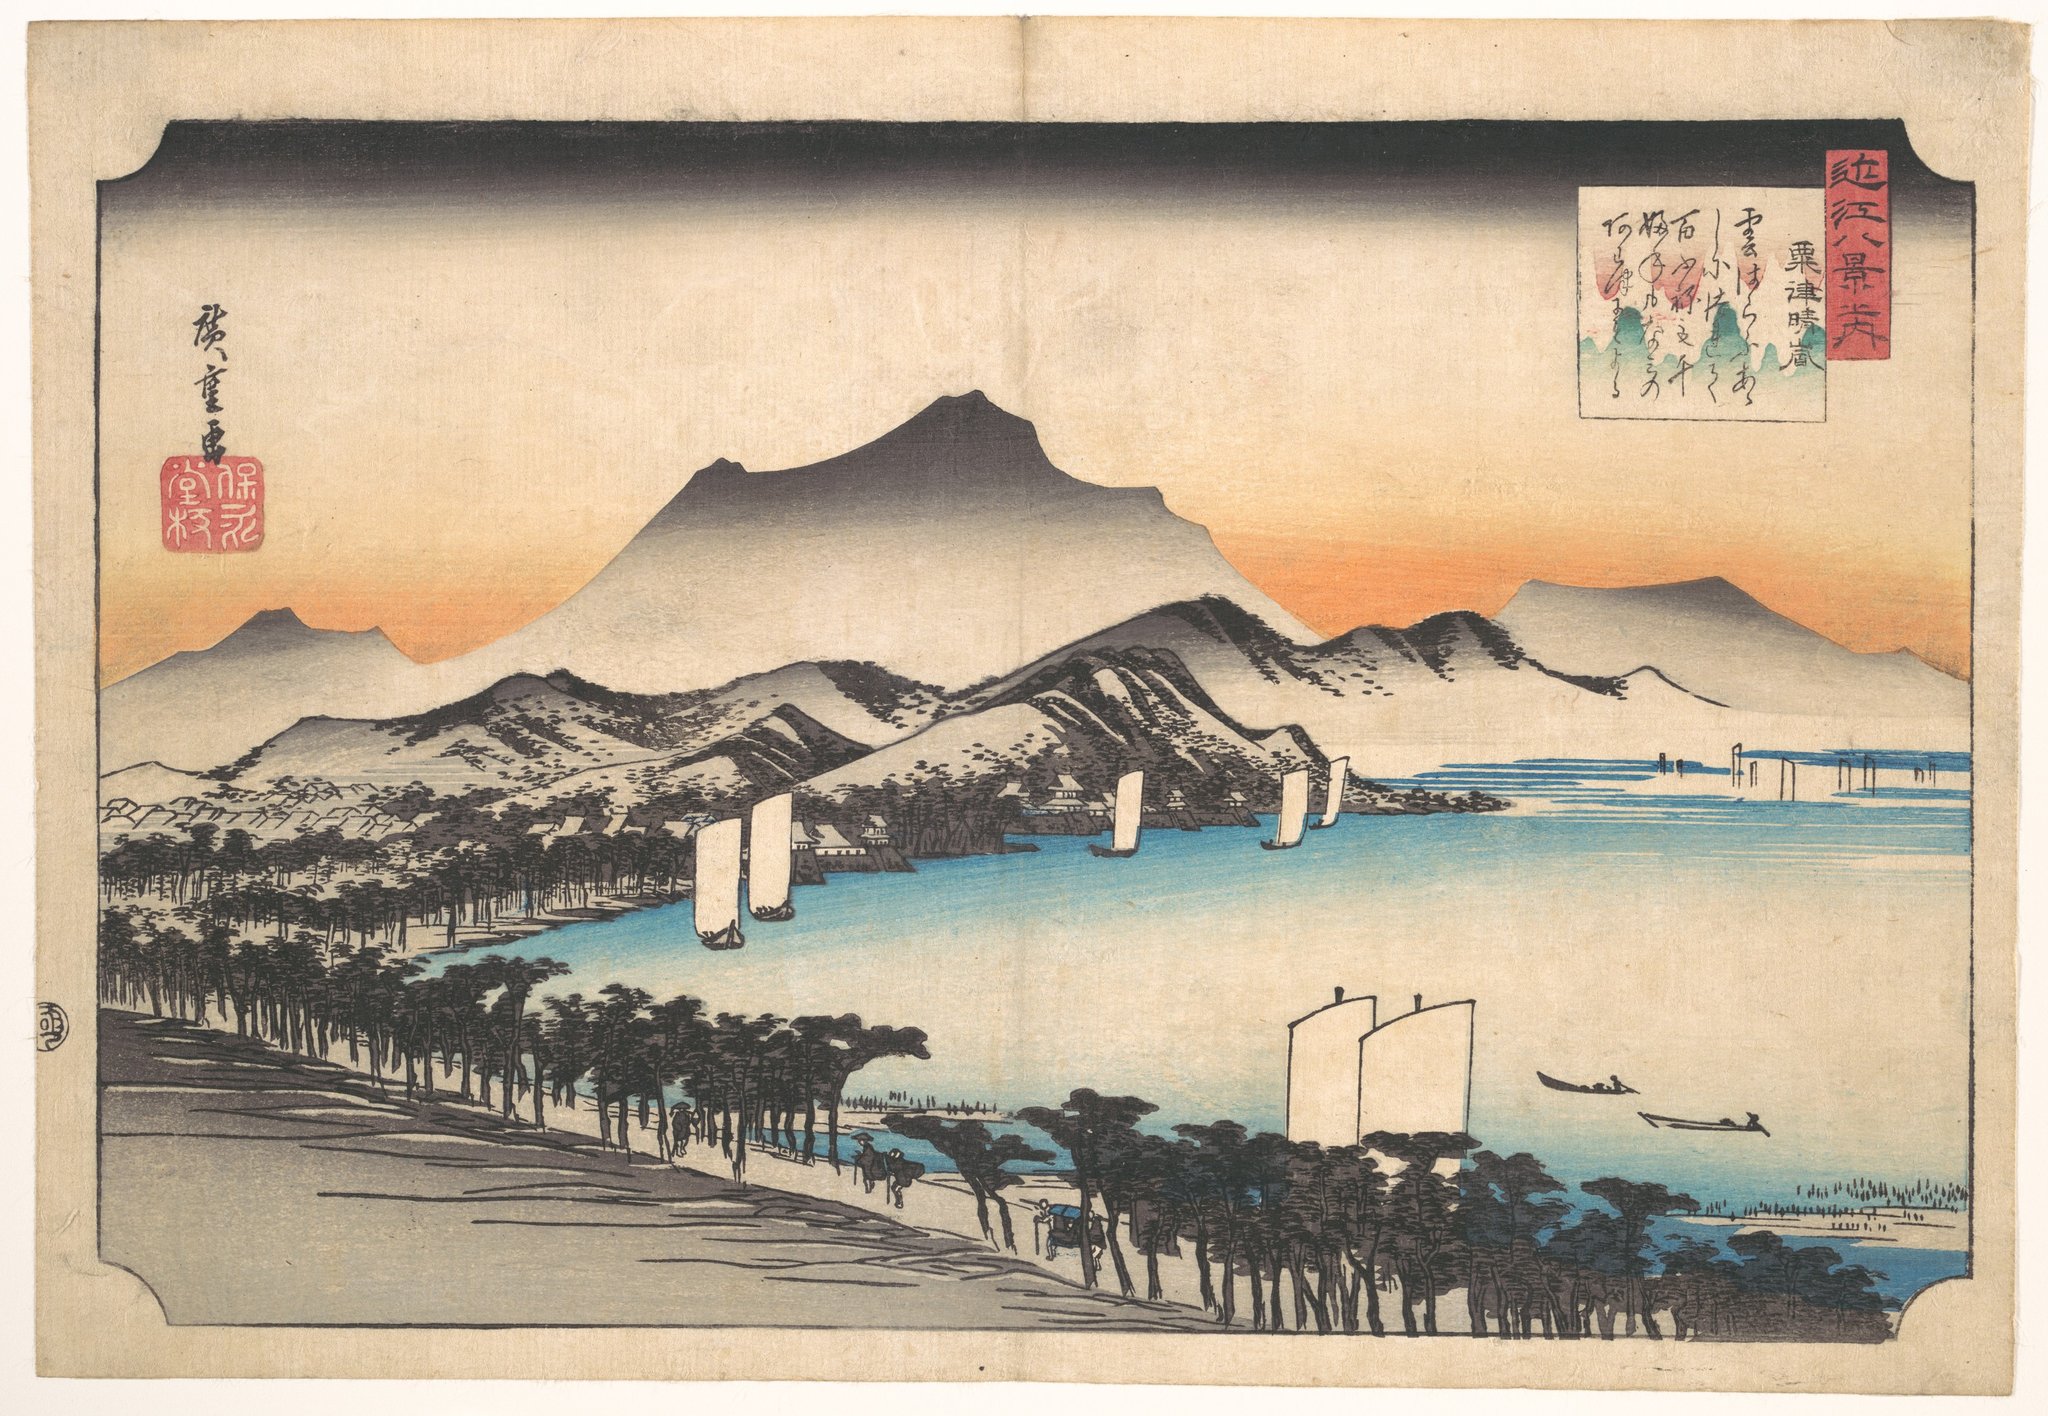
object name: print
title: Clearing Weather at Awazu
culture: japanese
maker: utagawa hiroshige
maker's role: artist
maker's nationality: japanese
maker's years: 1797-1858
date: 1832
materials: ink, paper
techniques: woodblock print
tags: mountains,landscapes,boats